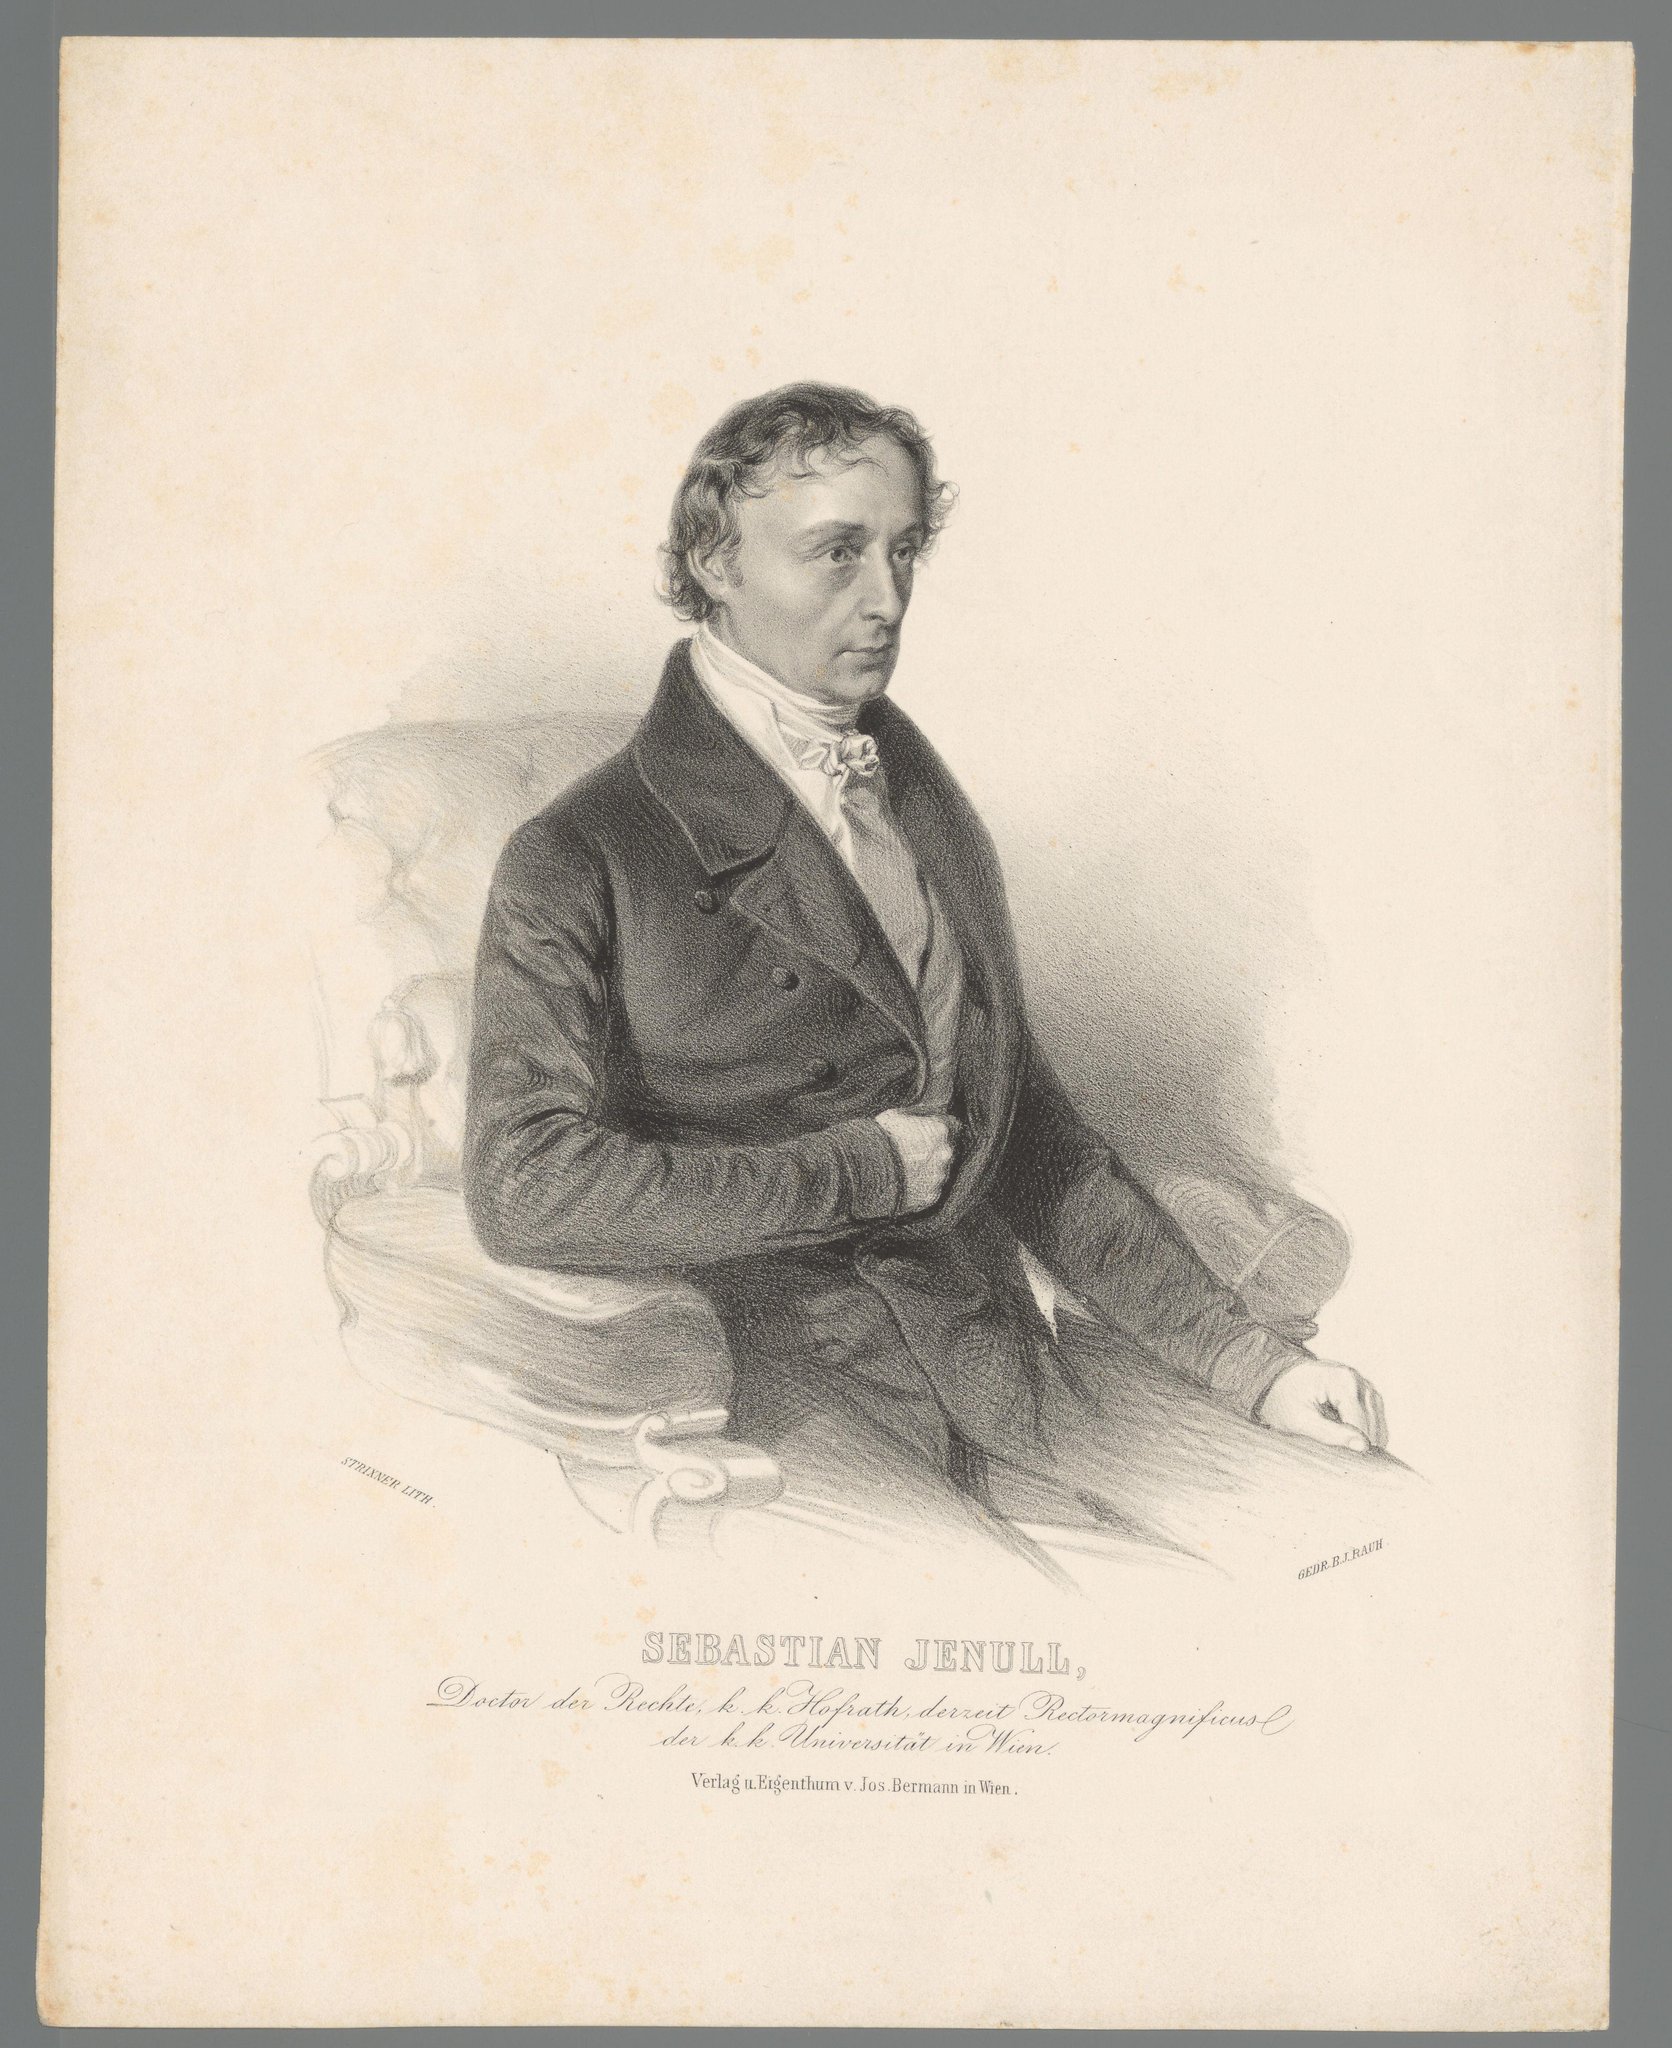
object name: print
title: Portret van Sebastian Jenull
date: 1830-1856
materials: paper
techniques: lithograph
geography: vienna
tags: armchair, seat, adult man, historical persons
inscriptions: collector's mark: Lugt 2228